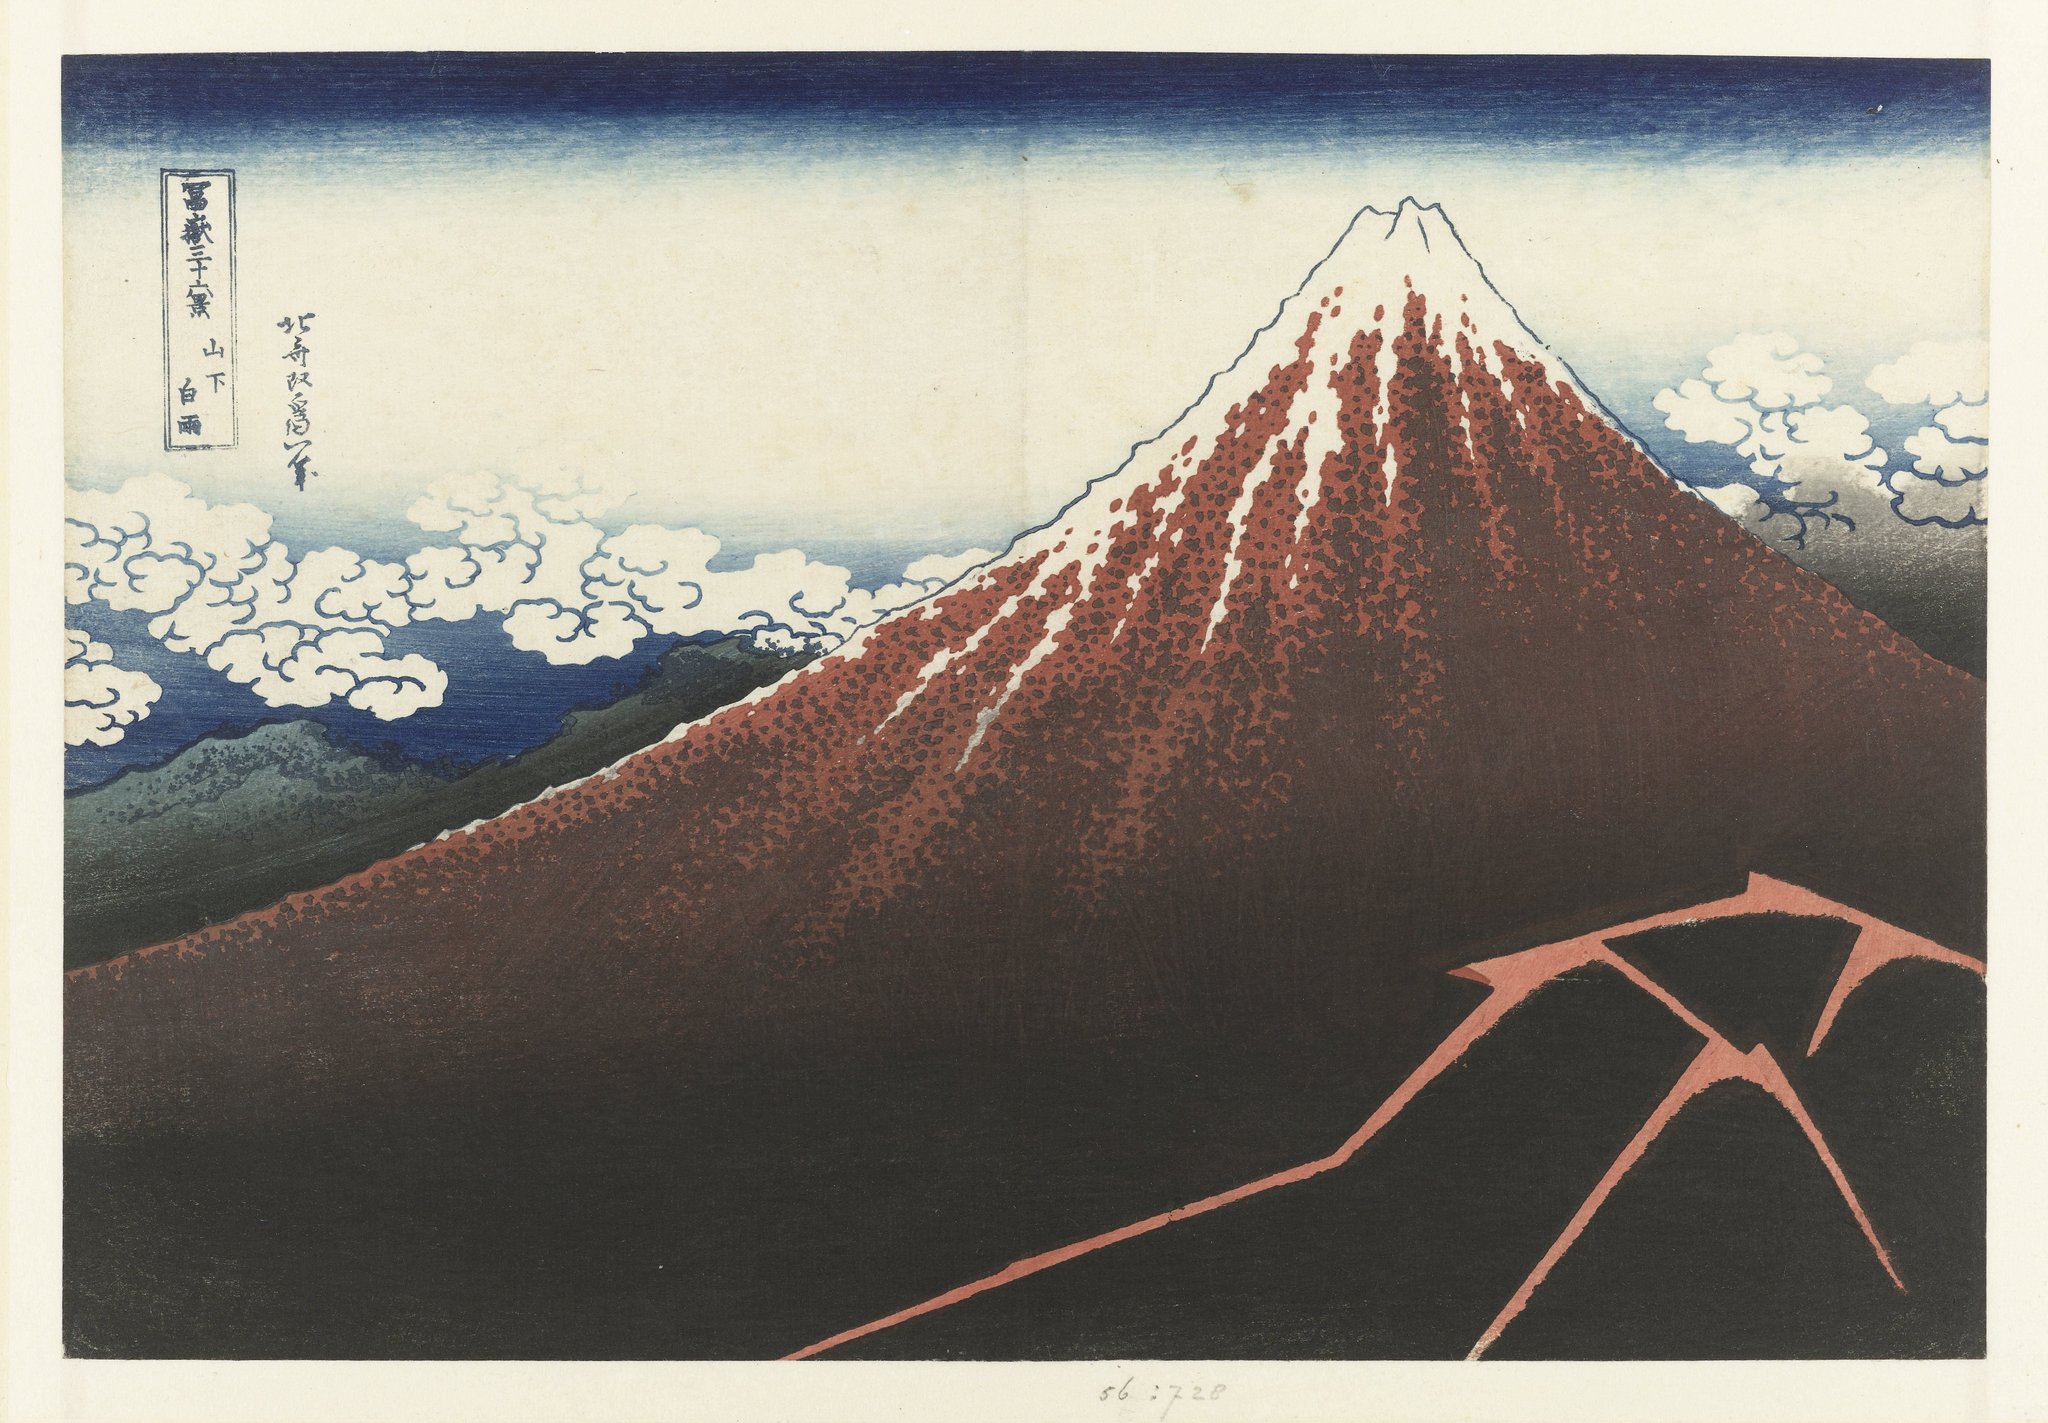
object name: print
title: Sanka hakuu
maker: katsushika hokusai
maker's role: draughtsman, print maker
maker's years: 1760-1849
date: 1829-1833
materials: paper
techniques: woodcut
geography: japan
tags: nimbus, i.e. rain clouds, lightning, flash of lightning, thunderbolt, mountains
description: Gezicht op de berg Fuji, rood met wit besneeuwde top en een donkere voet met bliksemflitsen; een bergketen en wolken op de achtergrond.